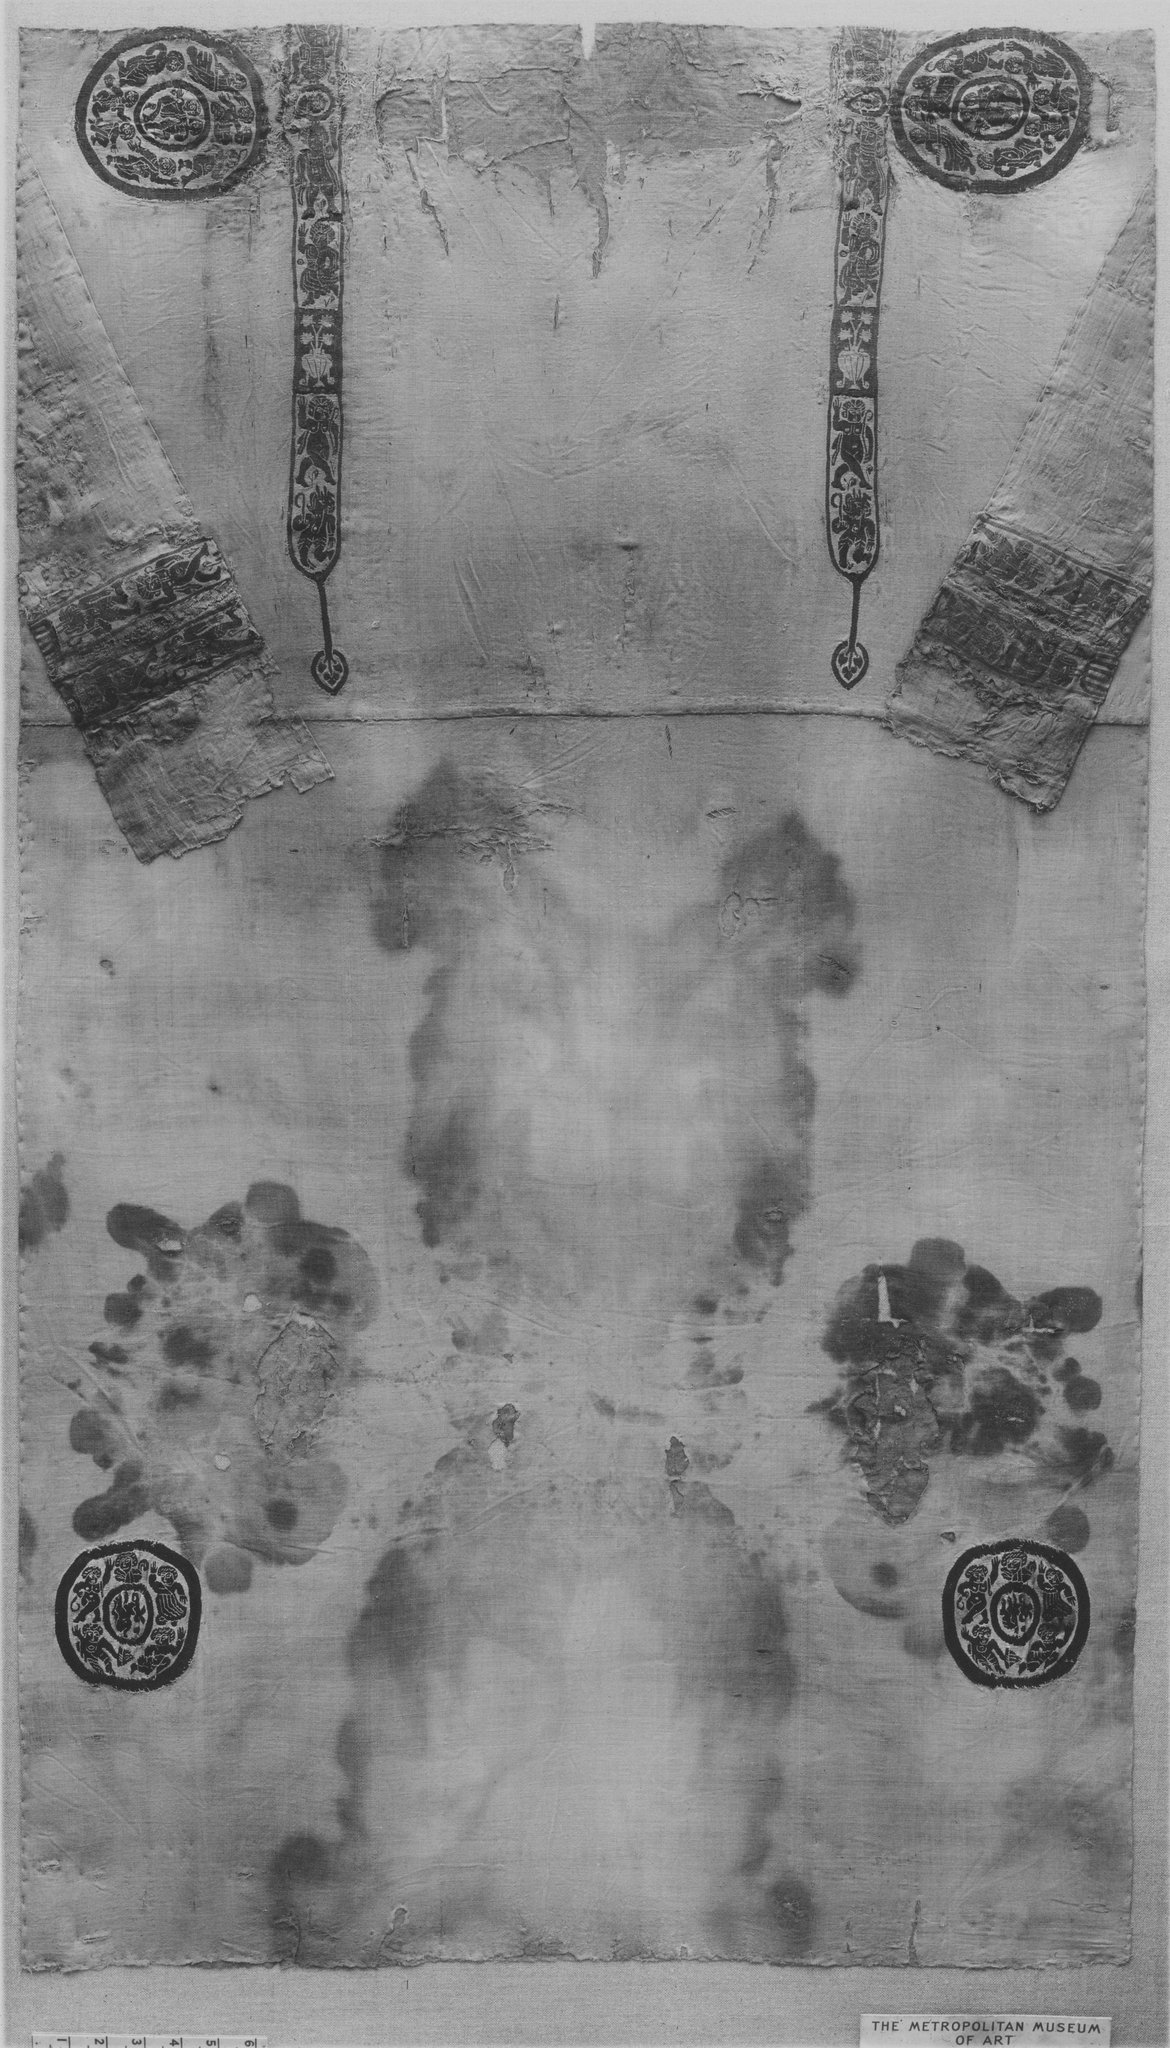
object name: tunic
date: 301-400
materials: linen, wool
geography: egypt